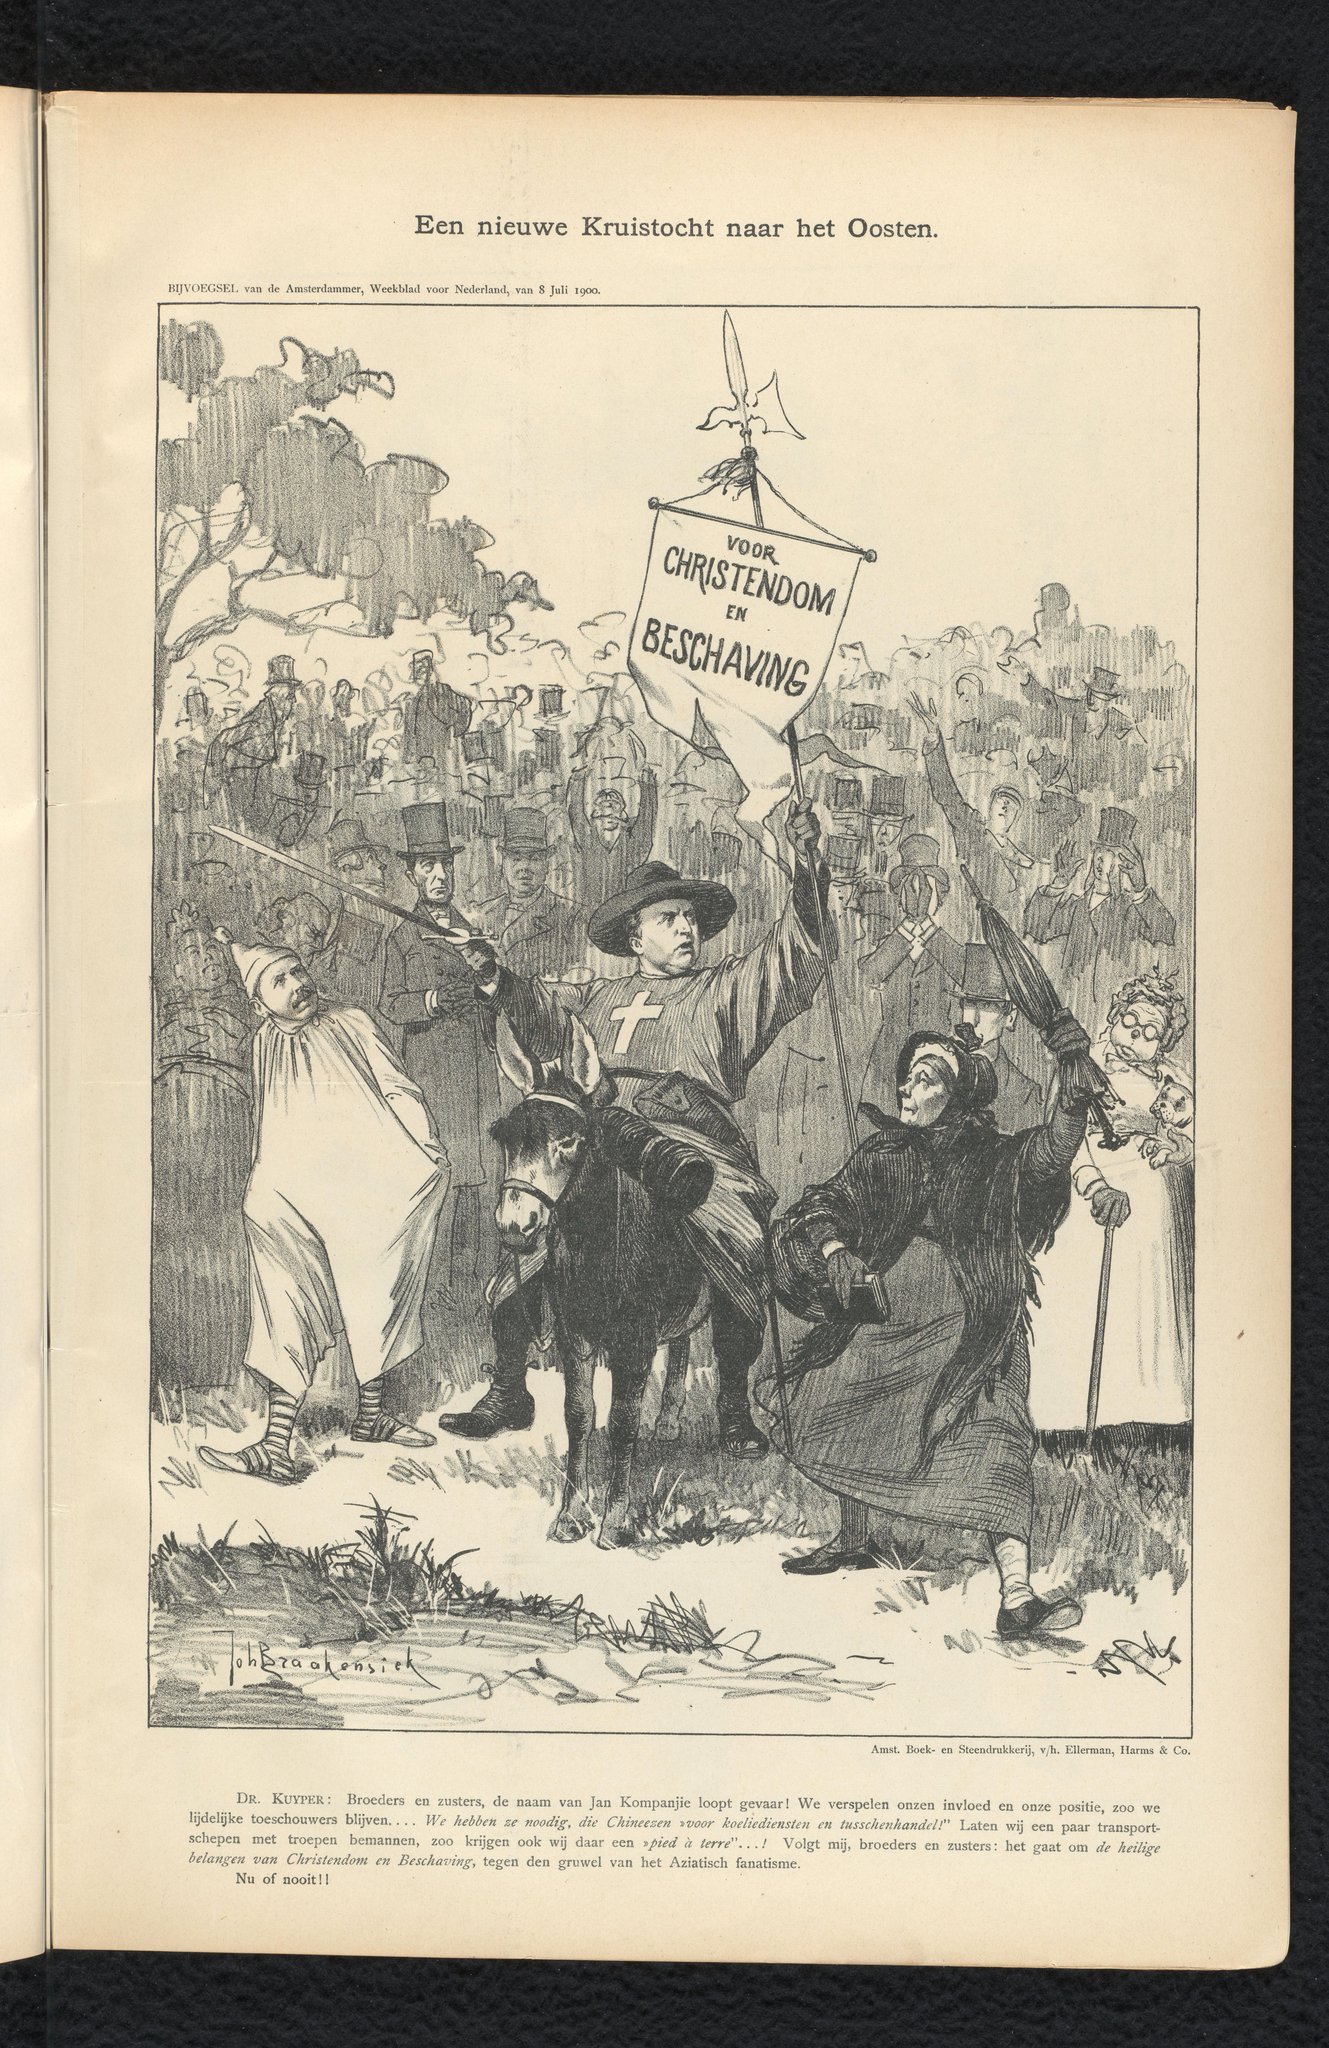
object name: cartoon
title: Een nieuwe Kruistocht naar het Oosten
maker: johan braakensiek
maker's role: draughtsman, print maker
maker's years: 1858-1940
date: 1900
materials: paper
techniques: lithograph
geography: amsterdam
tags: politician, the hague, abraham kuyper, rome, priest, herman johannes aloysius maria schaepman, riding a horse, ass, or mule; rider, horseman, militant proselytizing: religious war, crusade, etc., political caricatures and satires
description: Abraham Kuyper leidt gezeten op een ezeltje een potsierlijke meute Nederlanders (Troelstra als clown, Schaepman als vrouw met hondje) in een kruistocht onder het banier 'voor Christendom en Beschaving' tegen 'het Aziatisch fanatisme', de groeiende invloed van China in de wereldpolitiek.